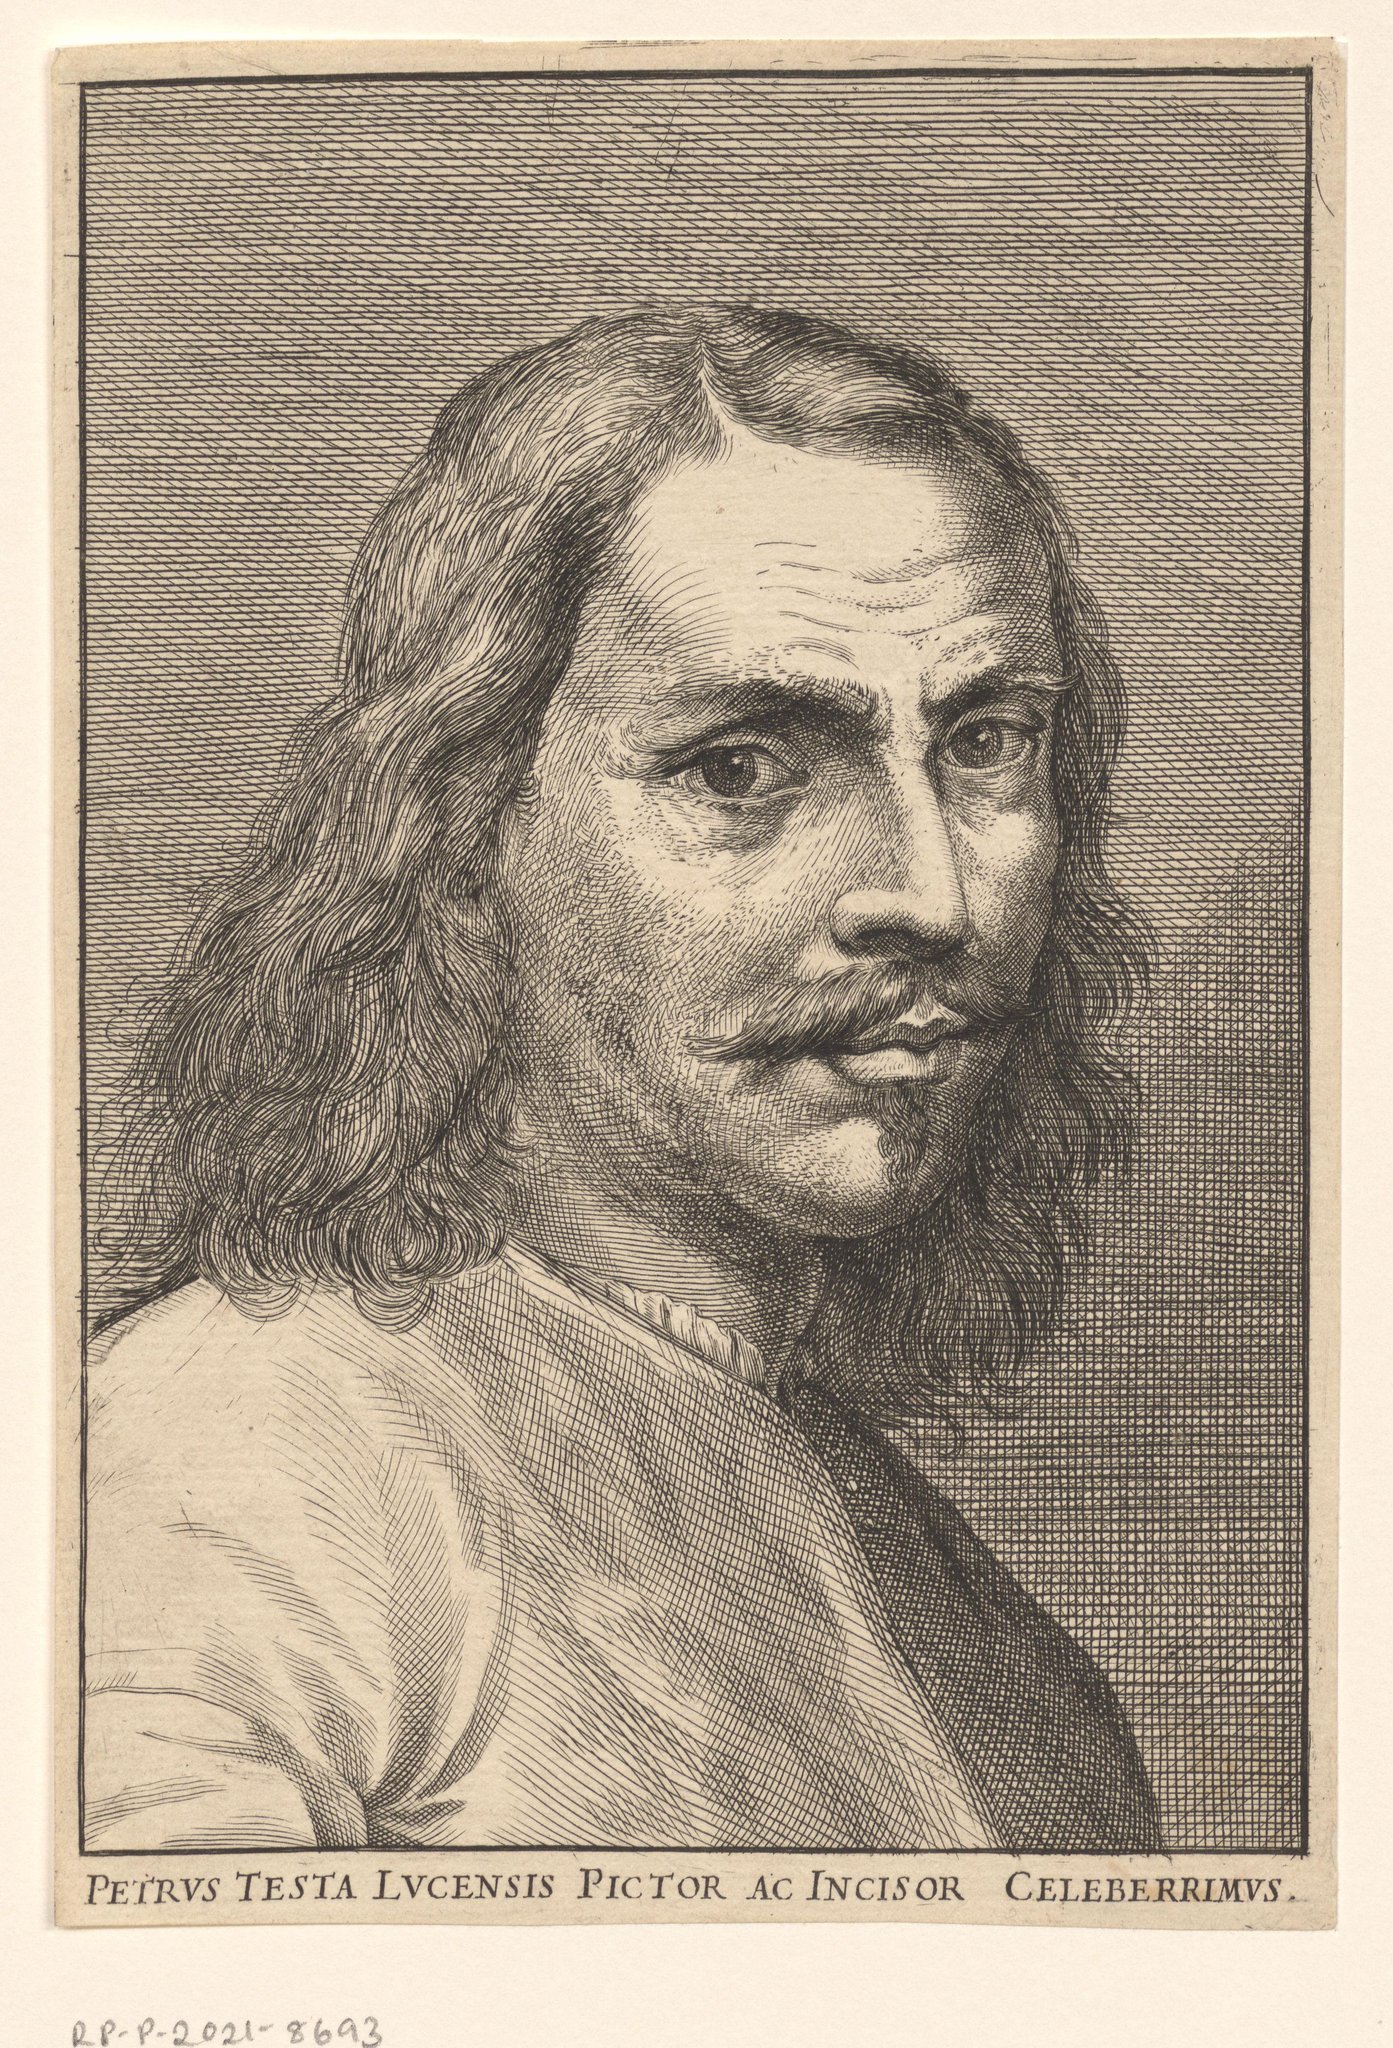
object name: print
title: Portret van Pietro Testa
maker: giovanni cesare testa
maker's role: print maker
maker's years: 1625-1660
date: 1640-1660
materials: paper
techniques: engraving, etching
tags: rome, painter, print maker, draughtsman, pietro testa, historical persons, portrait, self-portrait of painter, portrait, self-portrait of graphic artist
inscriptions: collector's mark: Lugt 240